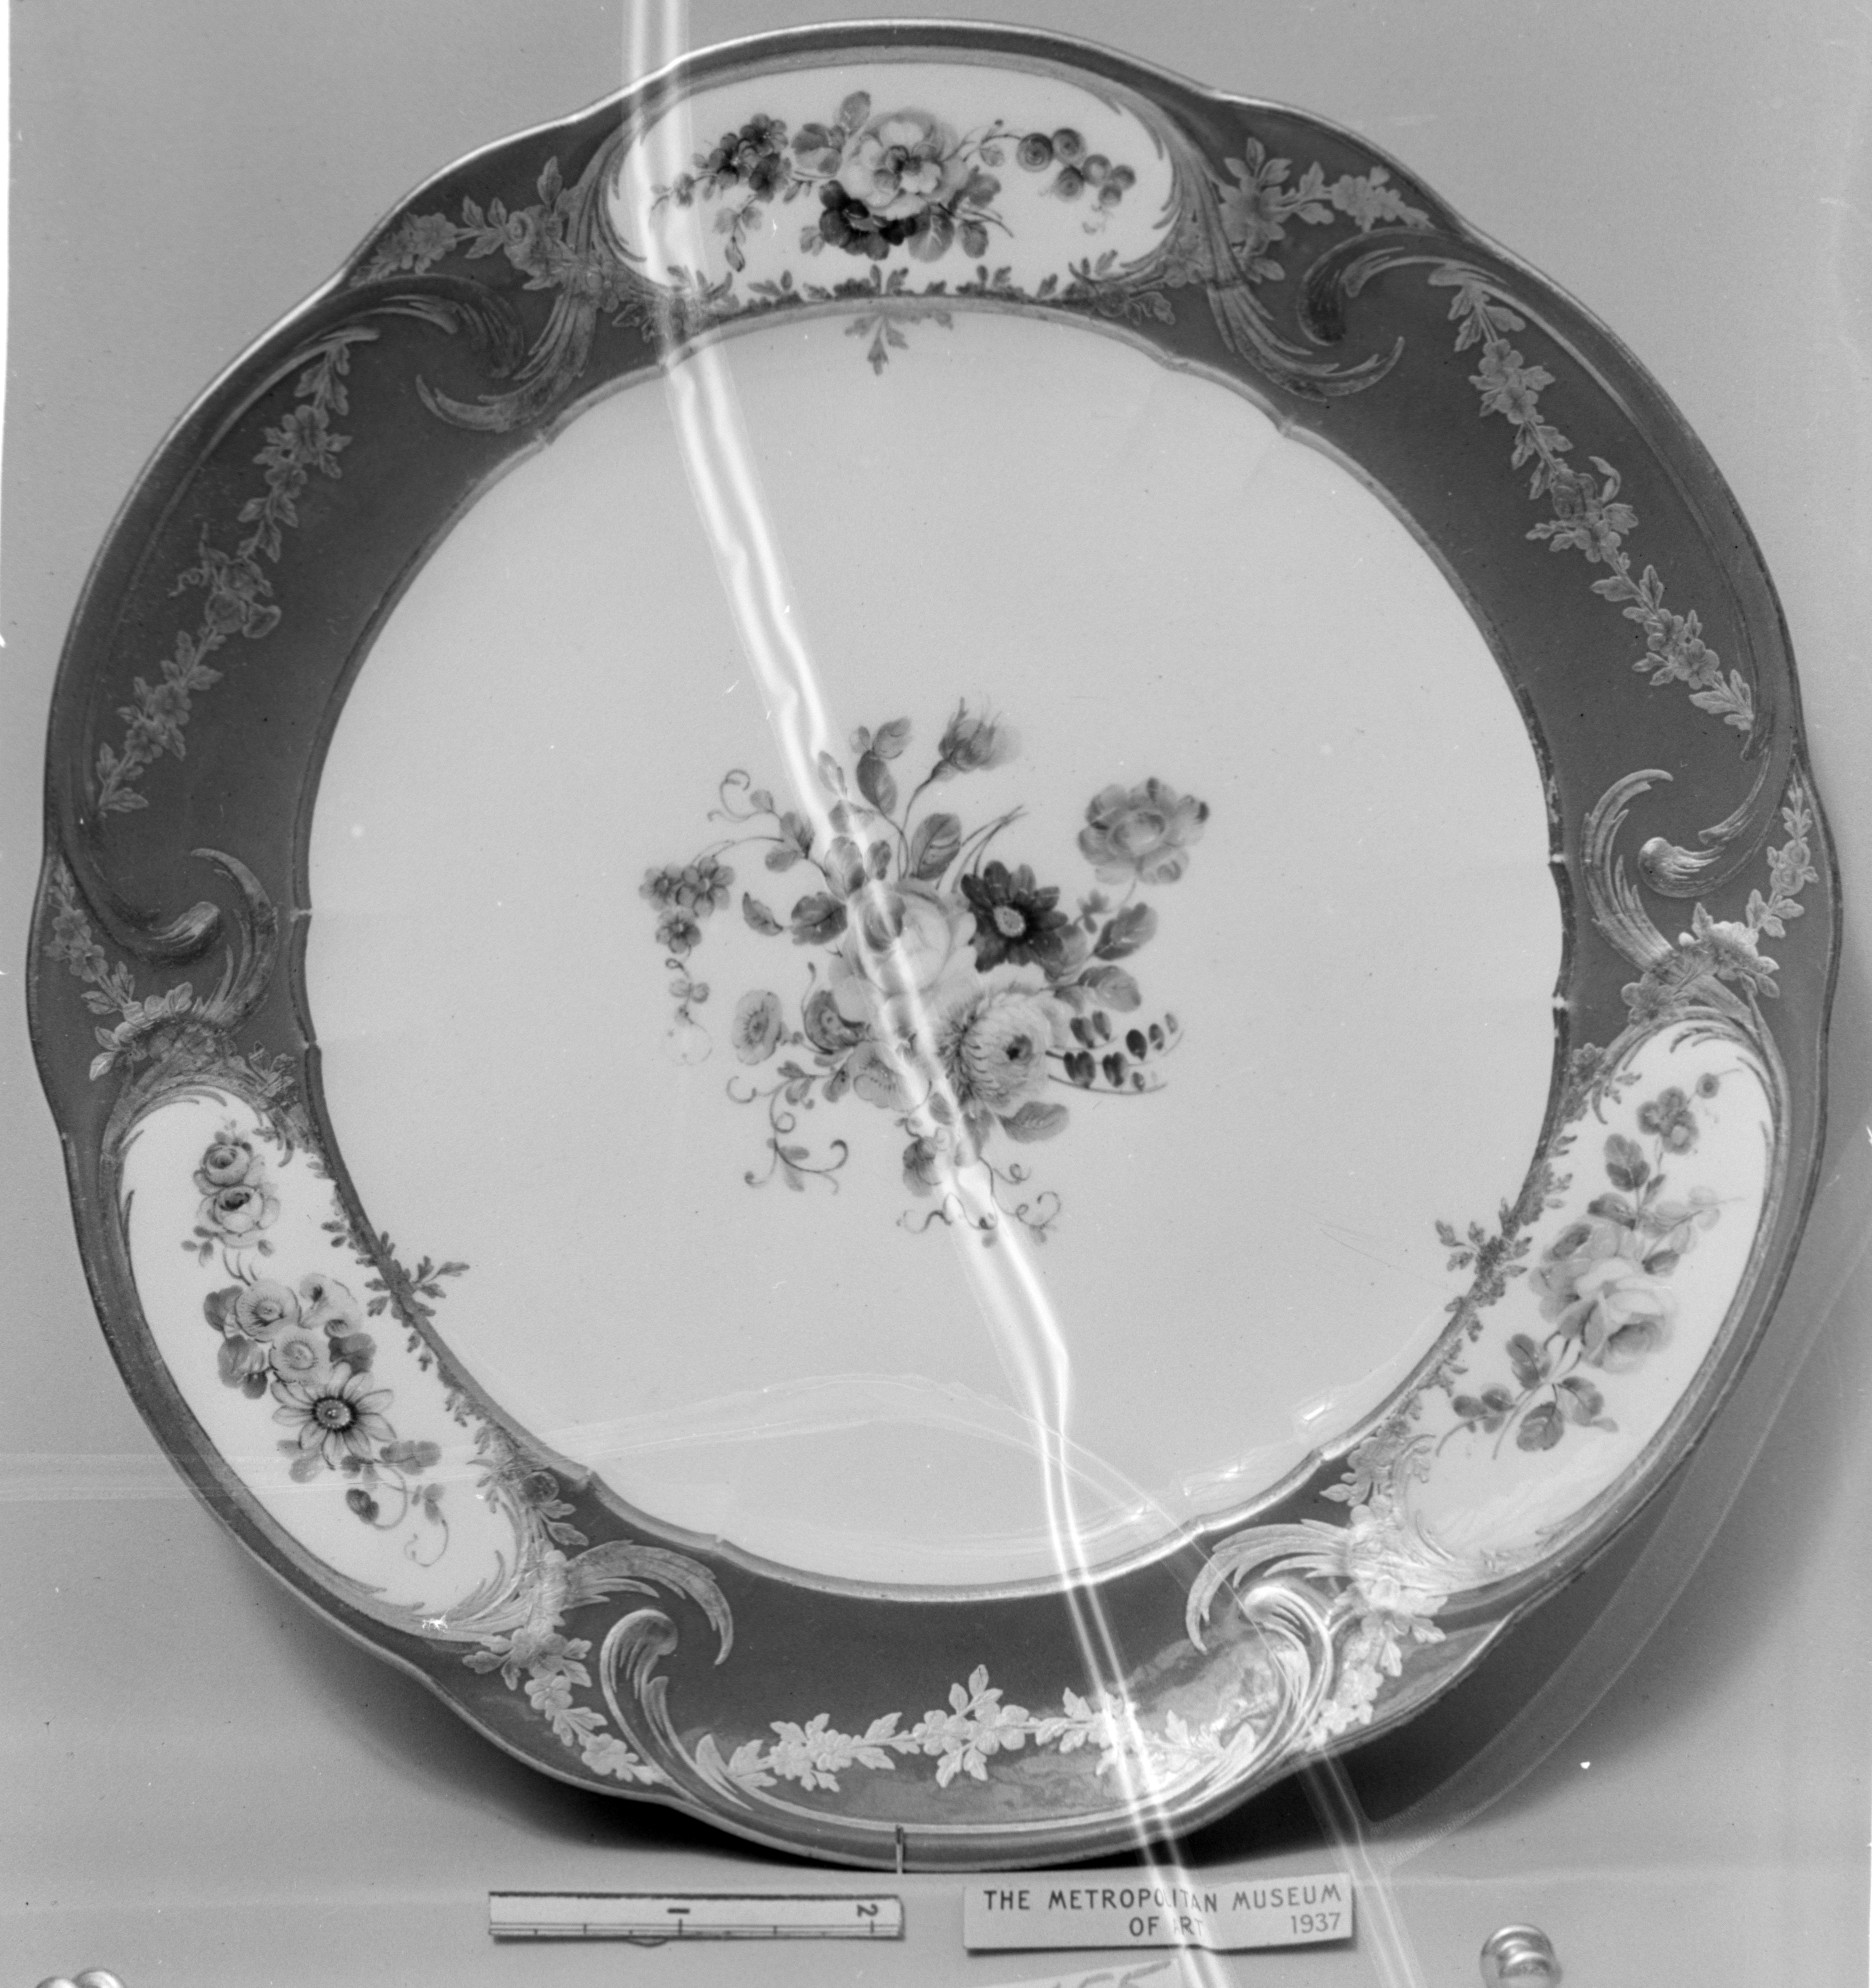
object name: plate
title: Plate (Assiette à palmes) (1 of 102) (part of a service)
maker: sèvres manufactory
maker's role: manufactory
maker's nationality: french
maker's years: 1740-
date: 1772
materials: soft paste porcelain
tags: flowers